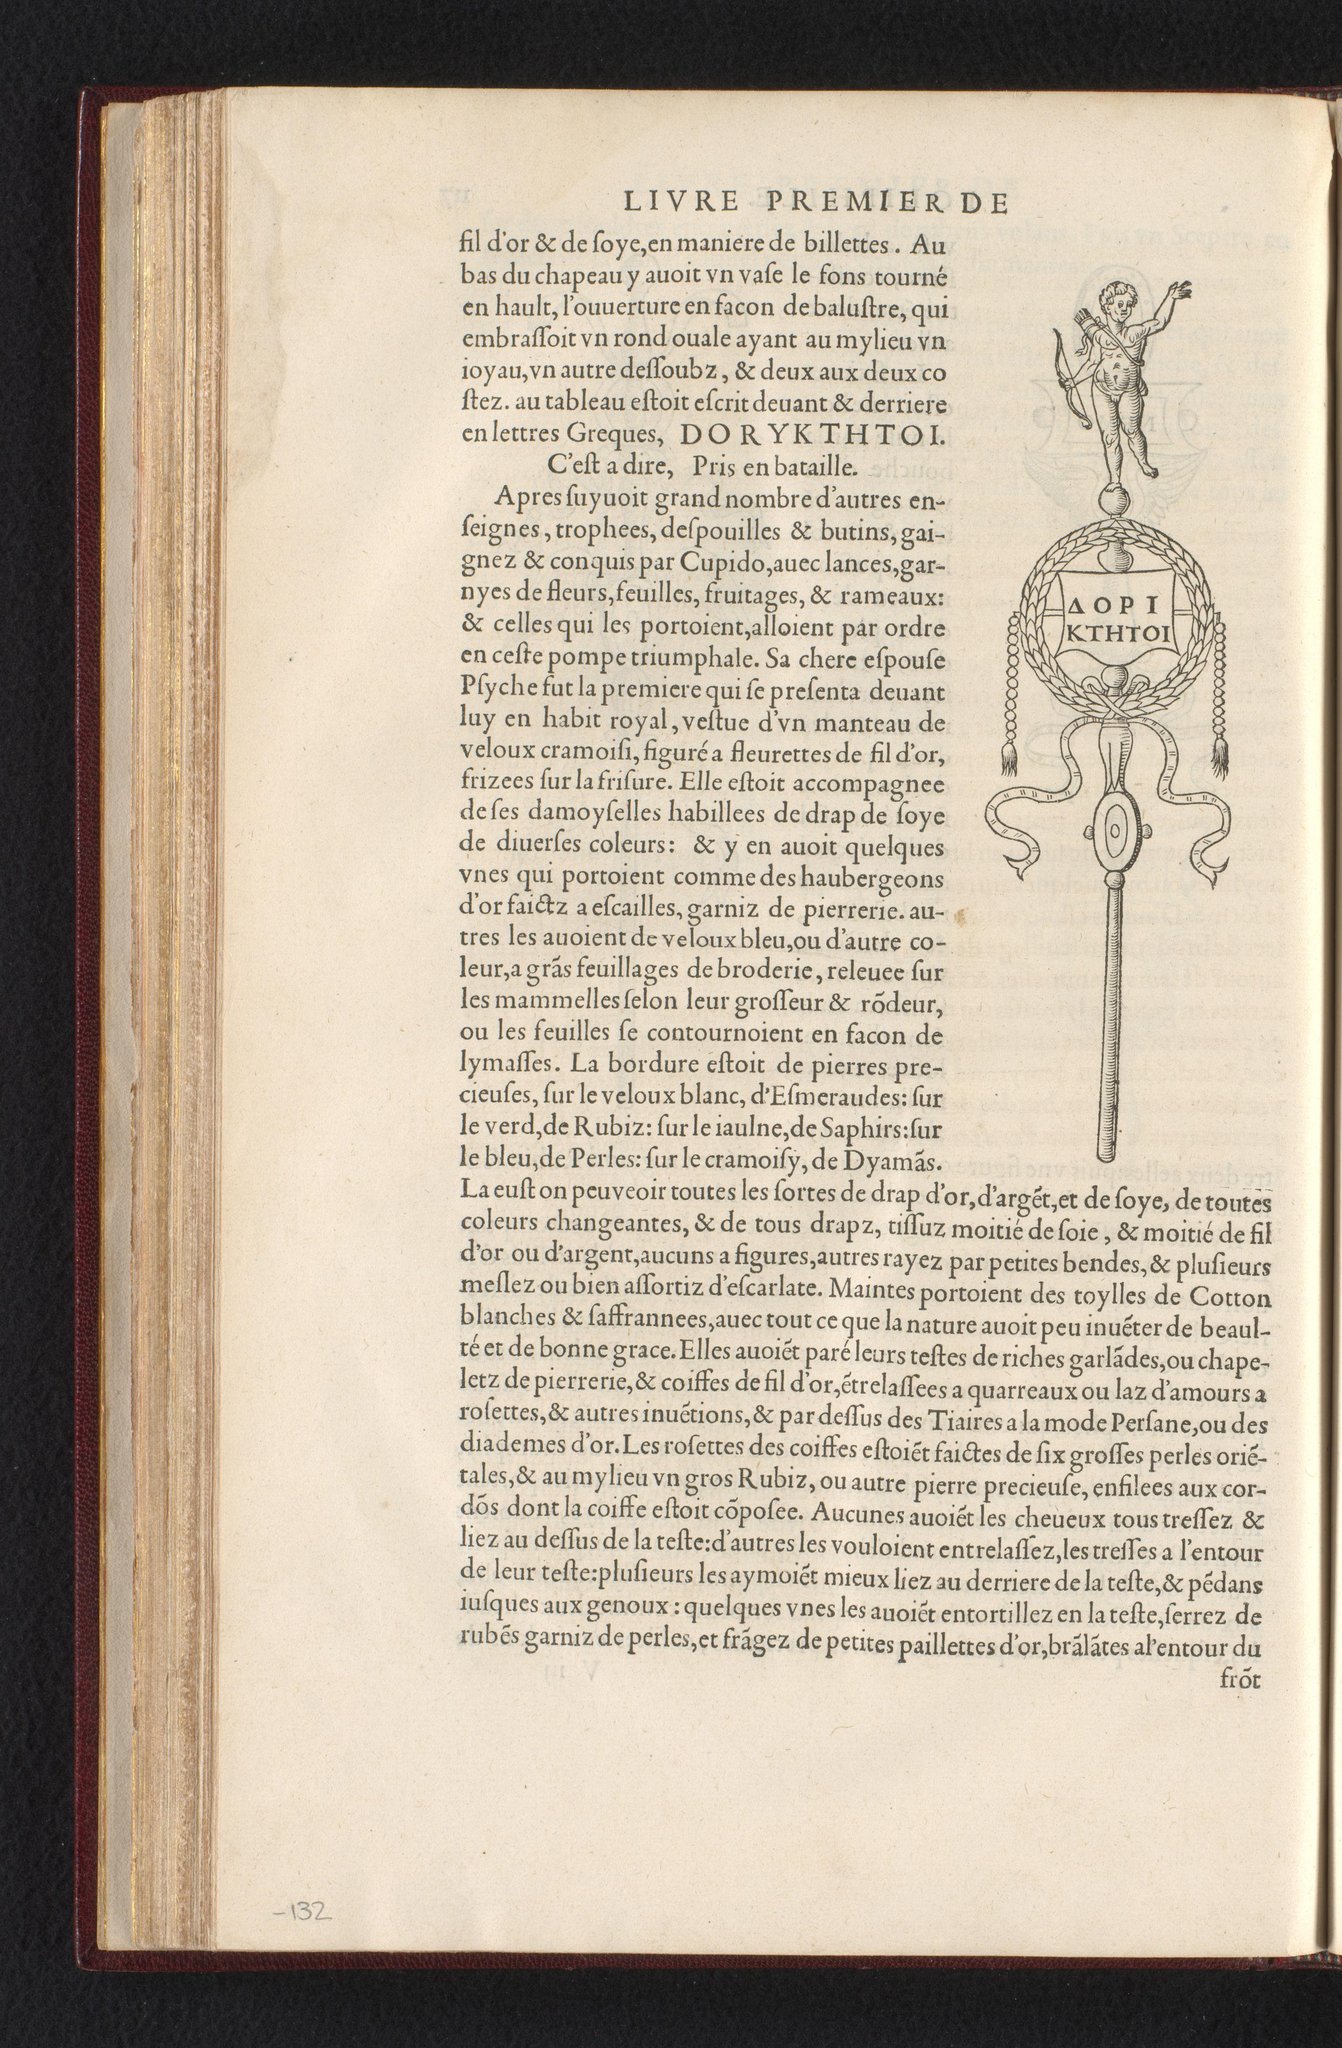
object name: book illustration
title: Militaire standaard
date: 1546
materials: paper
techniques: letterpress printing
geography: paris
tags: (scenes from) specific works of literature: colonna, hypnerotomachia poliphili, (military) flags and standards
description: Prent uit: Colonna, Francesco. Hypnerotomachie ou discours du songe de Poliphile, deduisant comme amour le combat a l'occasion de Polia. Parijs: Jacques Kerver, 1546, verso fol. 117.